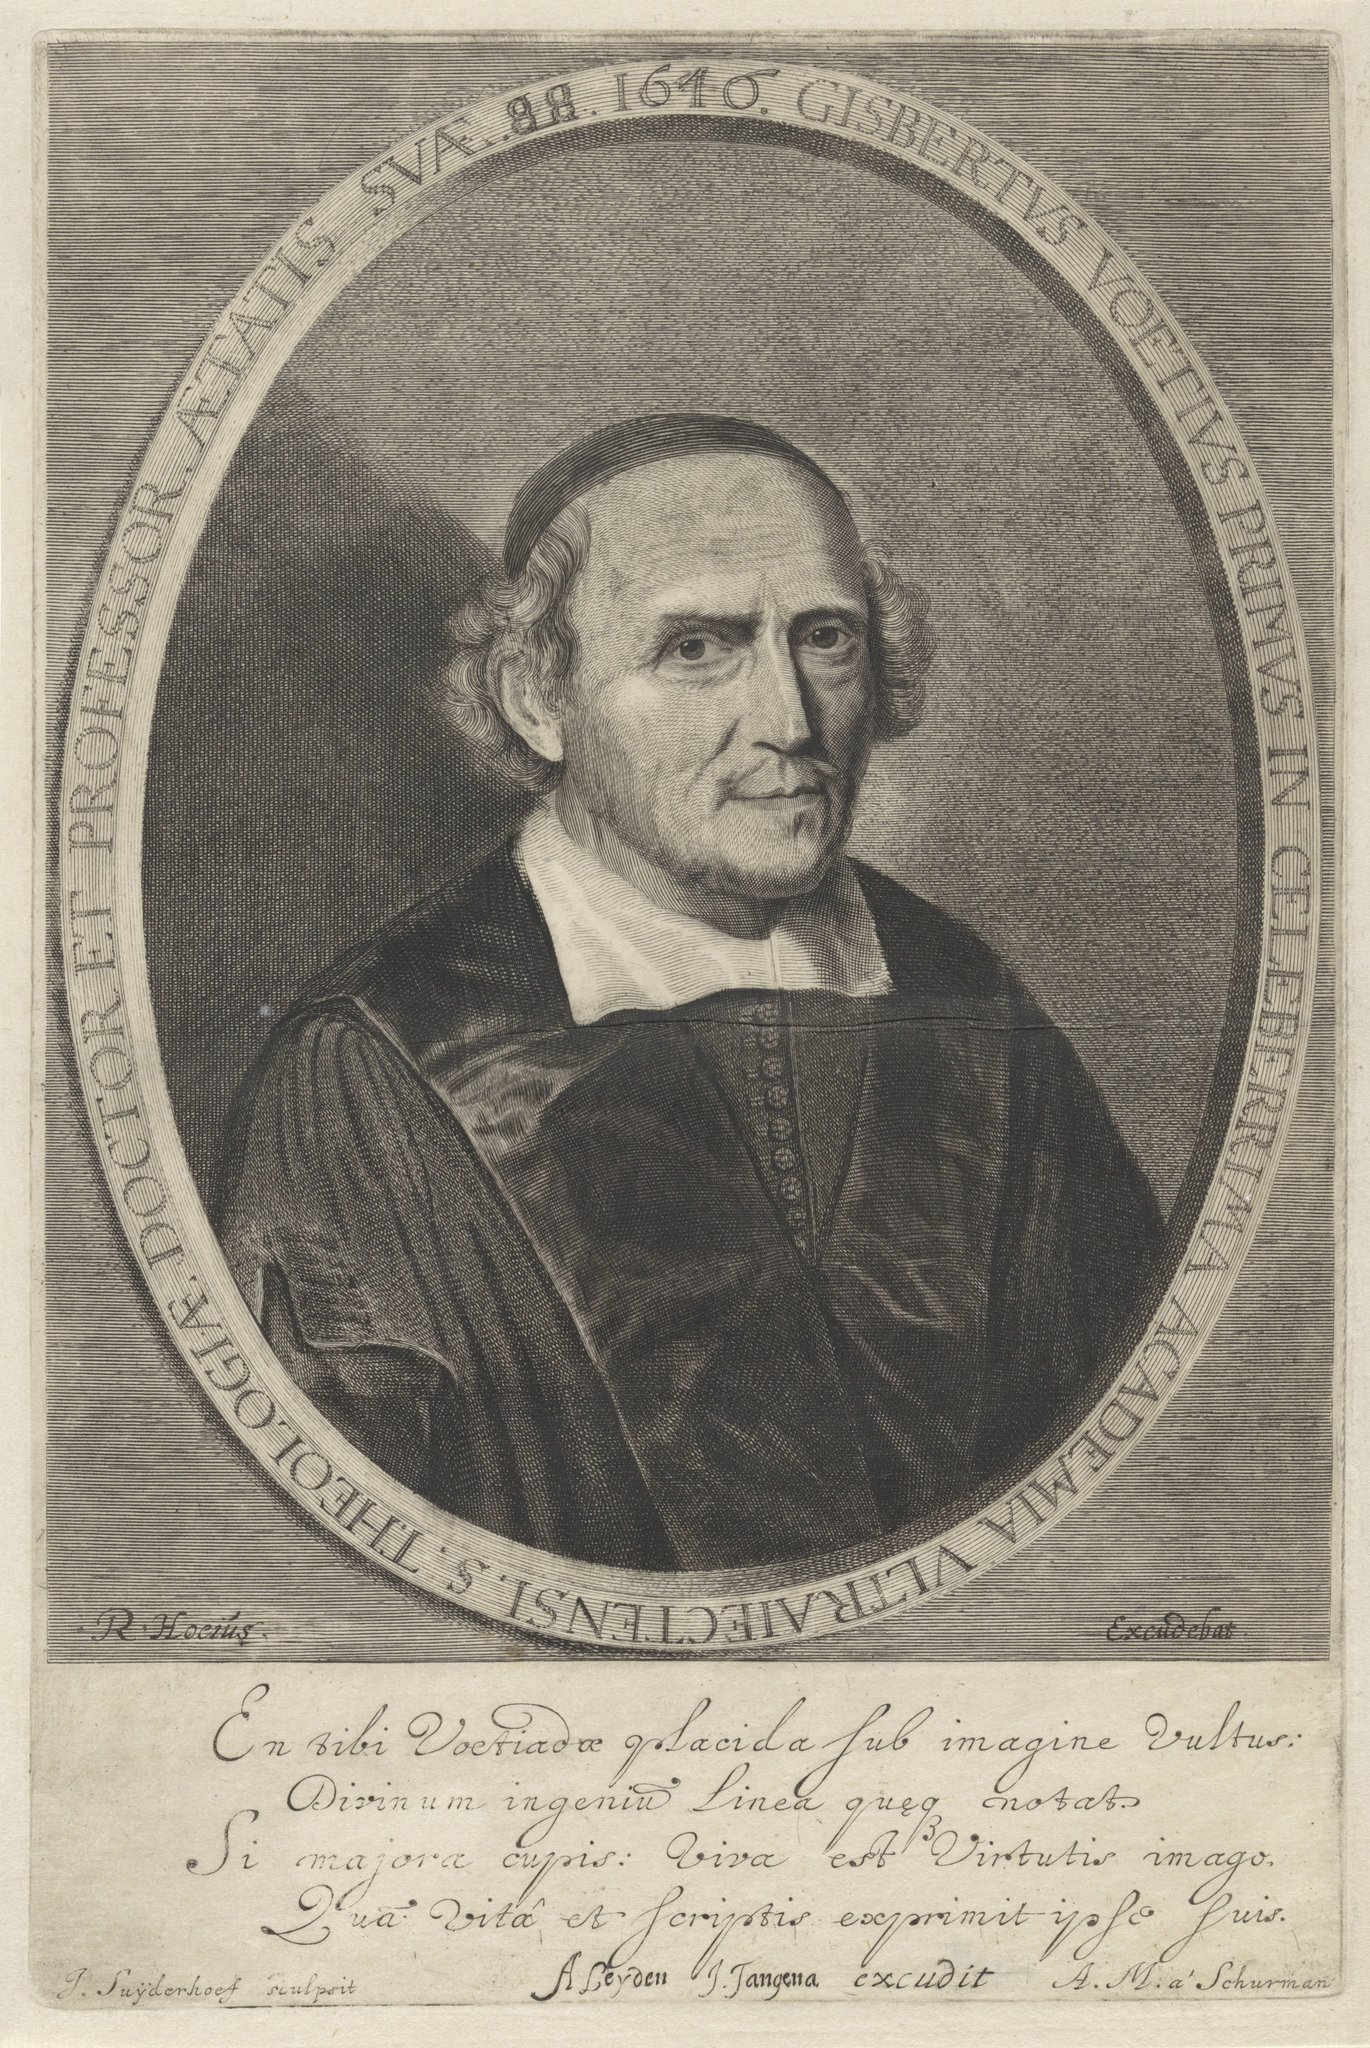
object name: print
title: Portret van Gijsbert Voet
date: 1687-1691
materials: paper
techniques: engraving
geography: haarlem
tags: utrecht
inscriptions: collector's mark: Lugt 2228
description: Portret van Gijsbert Voet, hoogleraar theologie aan de universiteit van Utrecht, op 88-jarige leeftijd. Onder het portret een vierregelig vers in het Latijn.